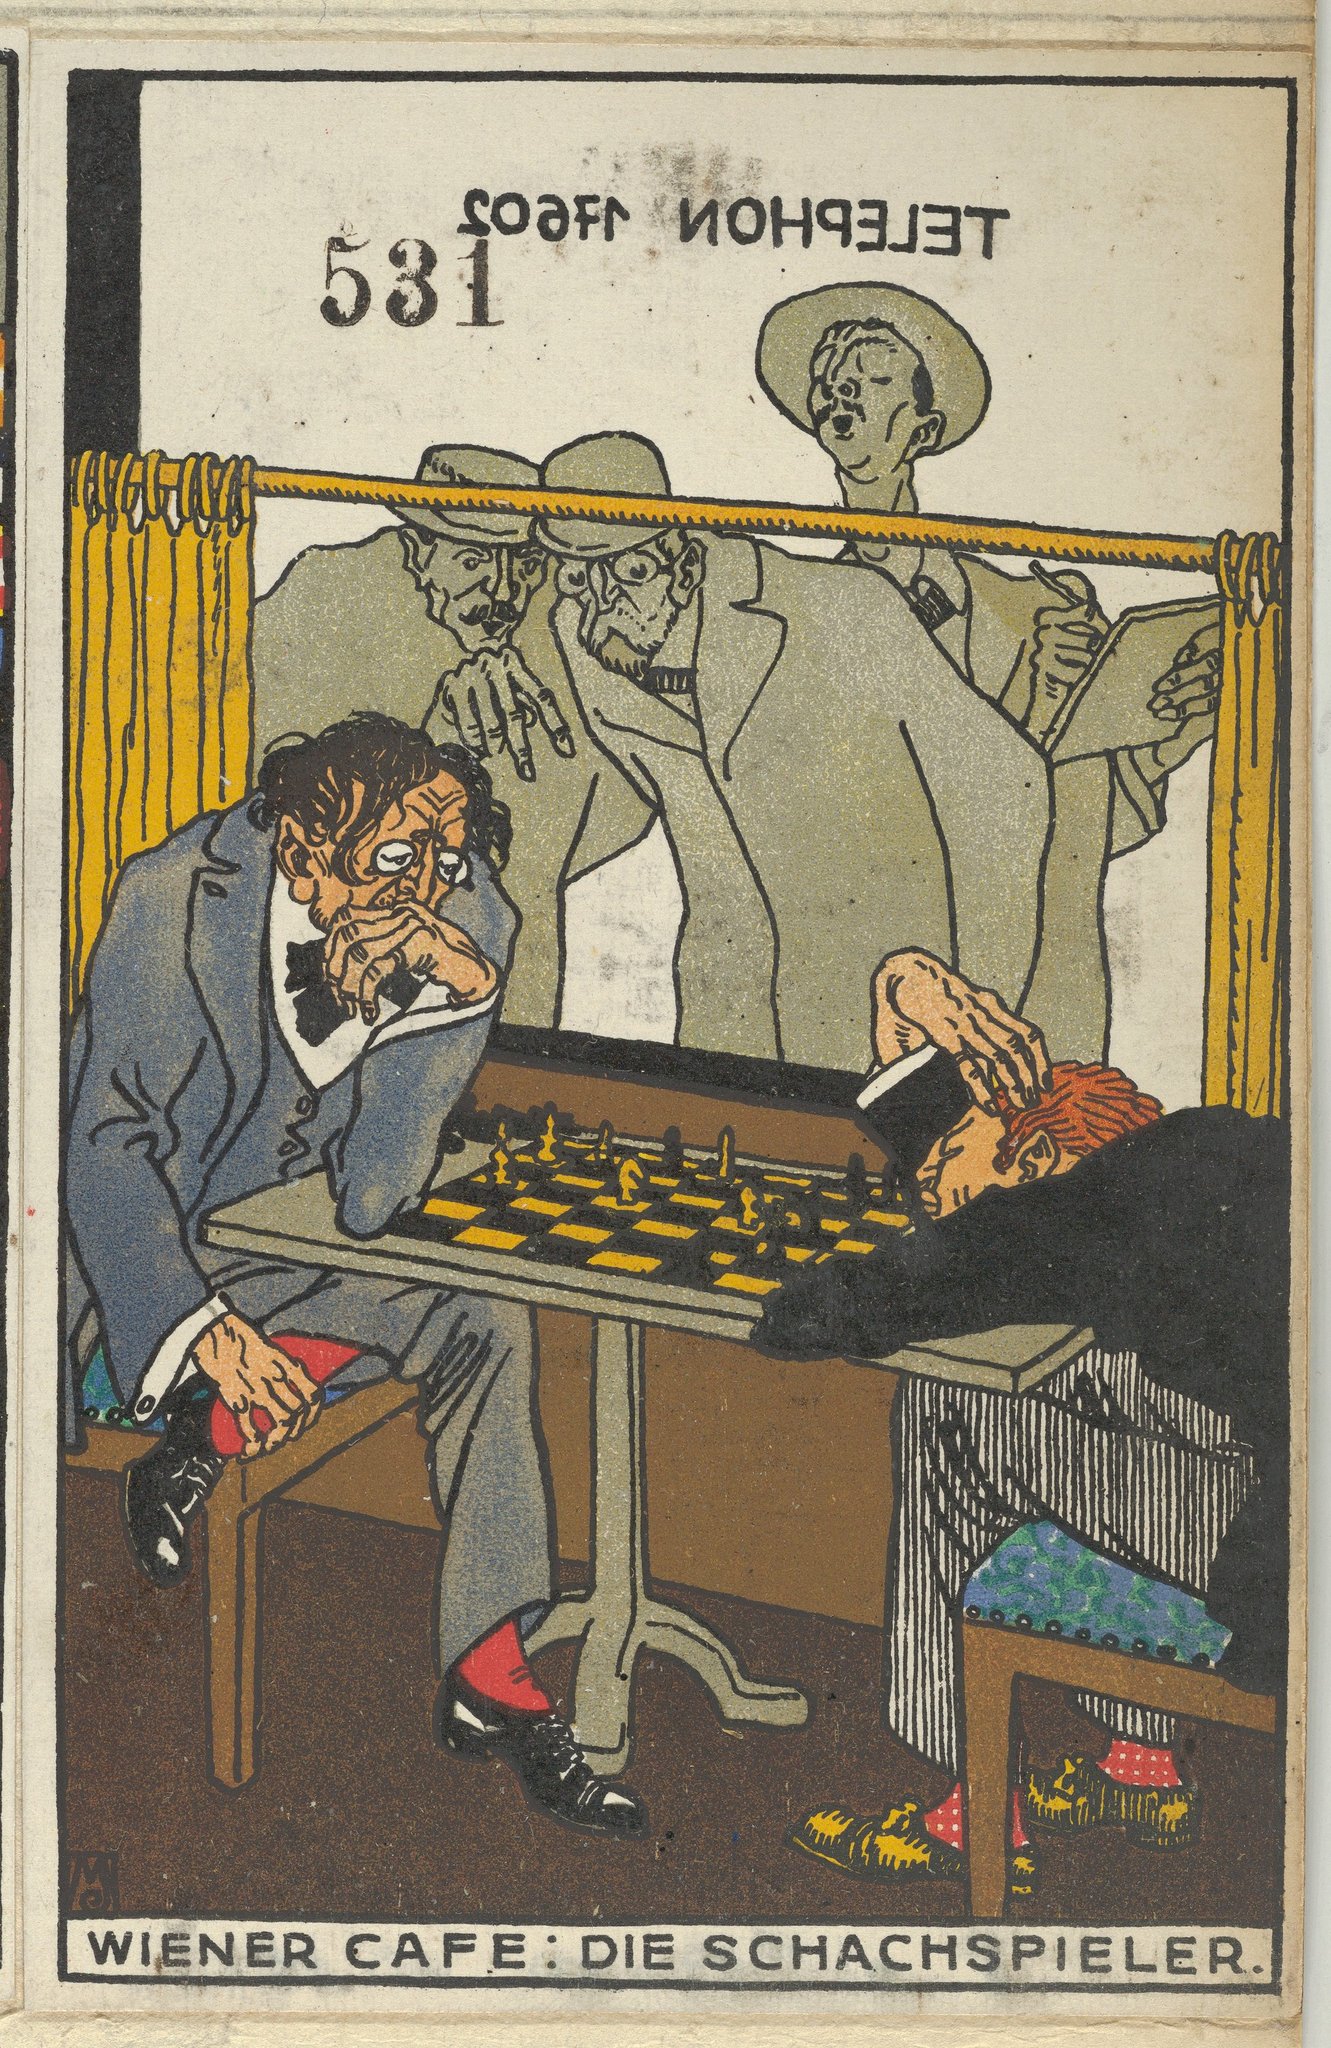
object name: print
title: Viennese Café: The Chess Players (Wiener Café: Die Schachspieler)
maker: moriz jung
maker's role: artist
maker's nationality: austrian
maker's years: 1885-1915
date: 1911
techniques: lithograph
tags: men,chess